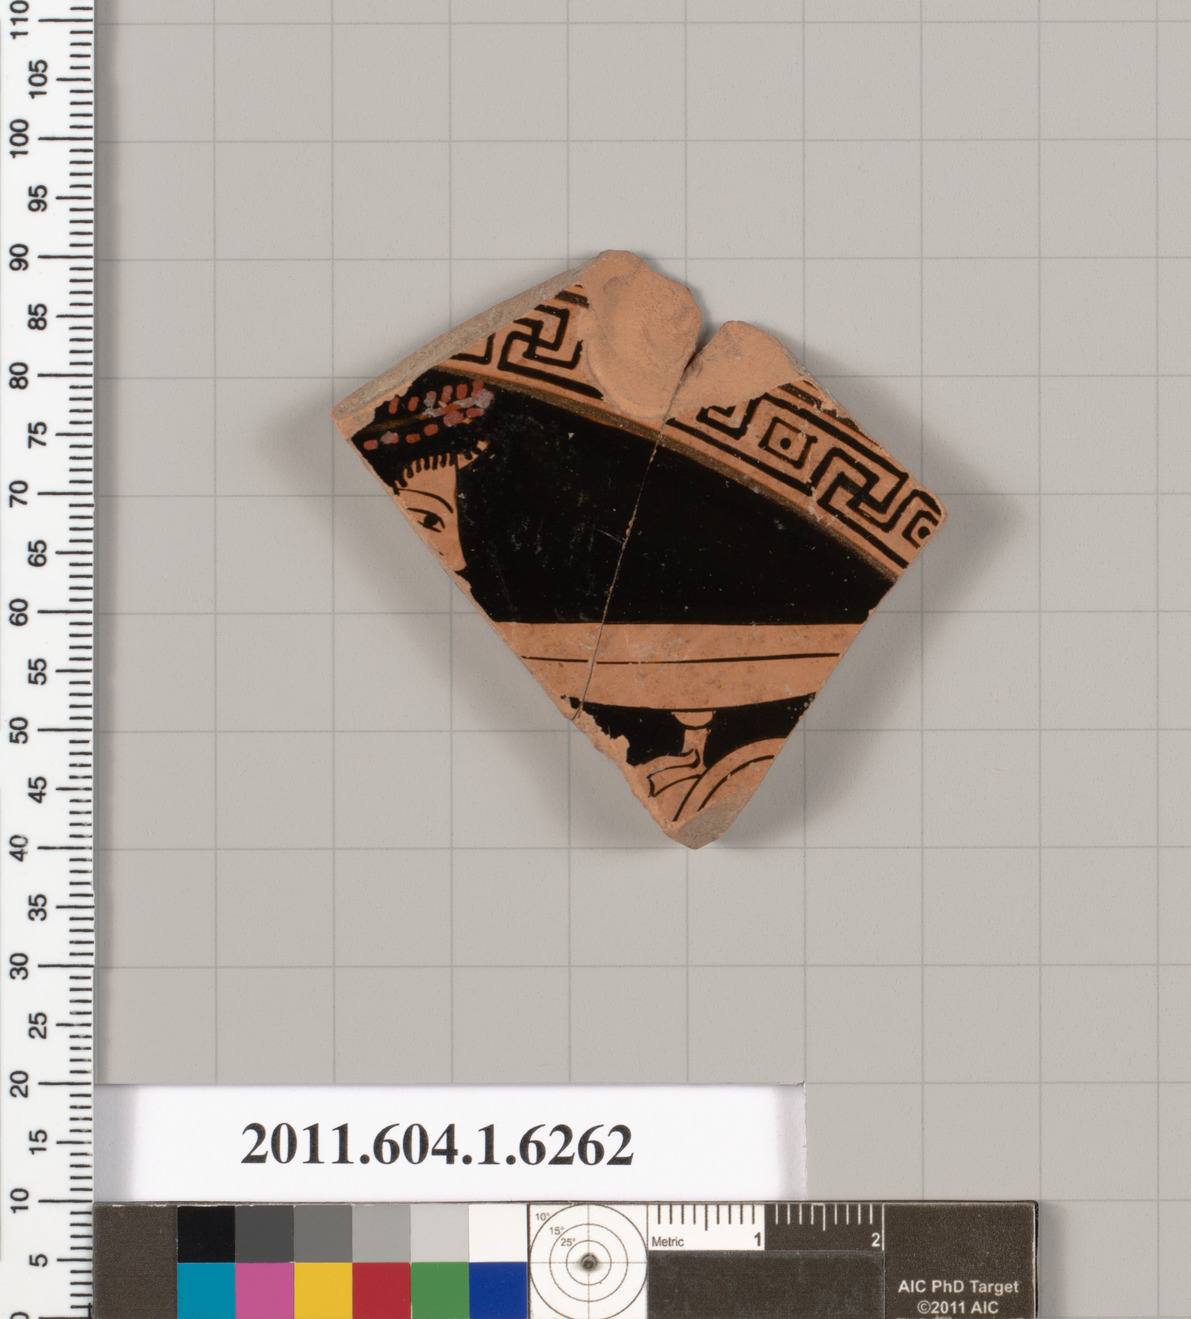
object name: kylix fragment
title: Terracotta fragment of a kylix (drinking cup)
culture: greek, attic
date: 500-480 BCE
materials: terracotta